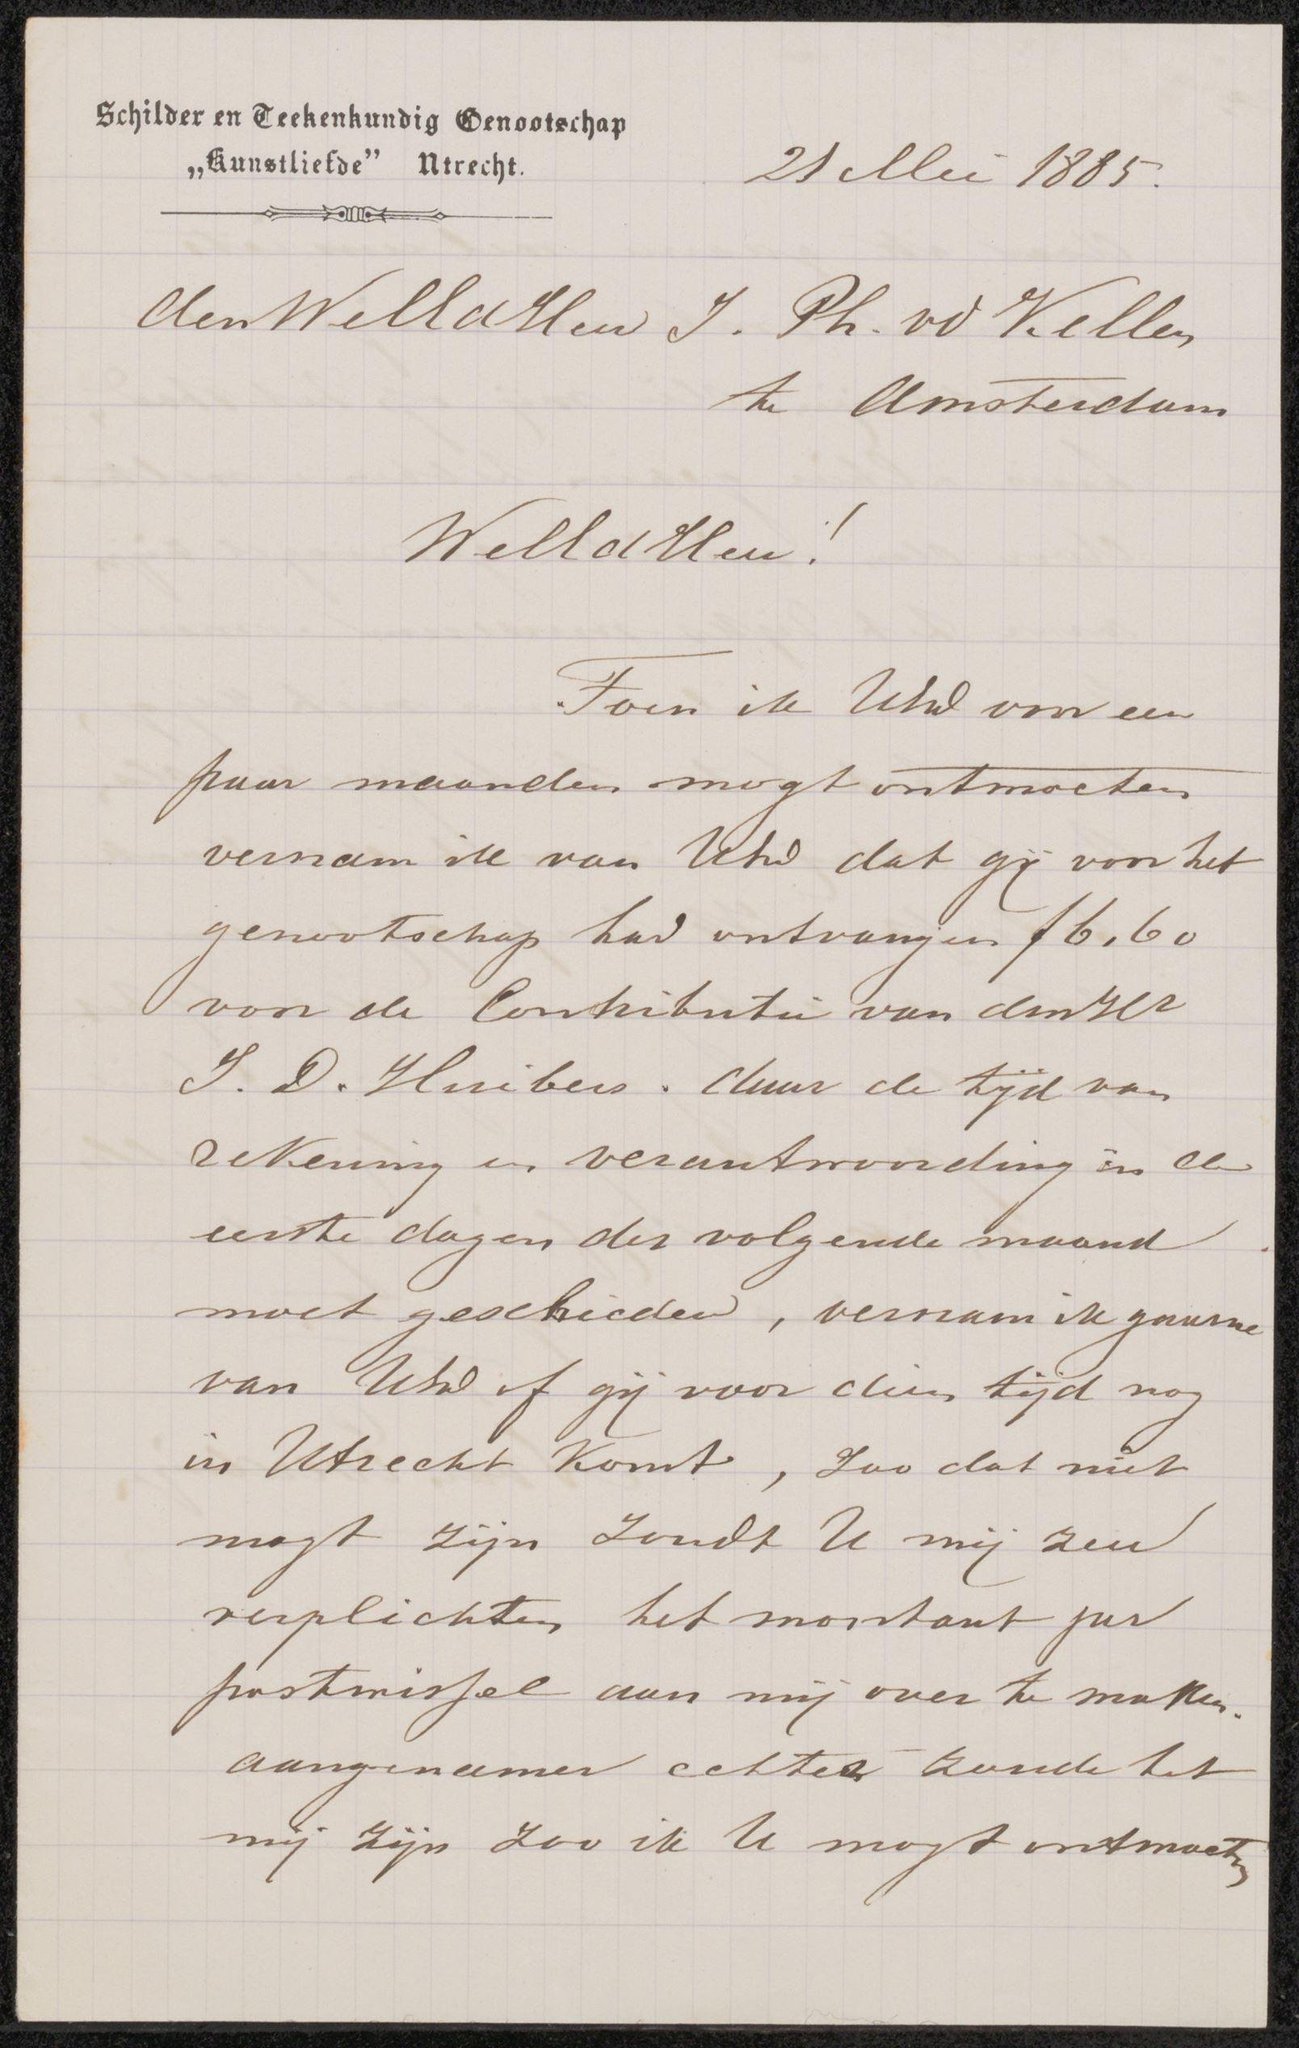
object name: letter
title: Brief aan Philip van der Kellen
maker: adrianus van everdingen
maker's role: print maker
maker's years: 1832-1912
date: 1885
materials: ink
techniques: pen, printing, writing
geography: utrecht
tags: painter, jan derk huibers, rijksmuseum amsterdam, painting (including book-illumination, miniature-painting), exhibition ~ art, money, utrecht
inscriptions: collector's mark: ‘RPK’